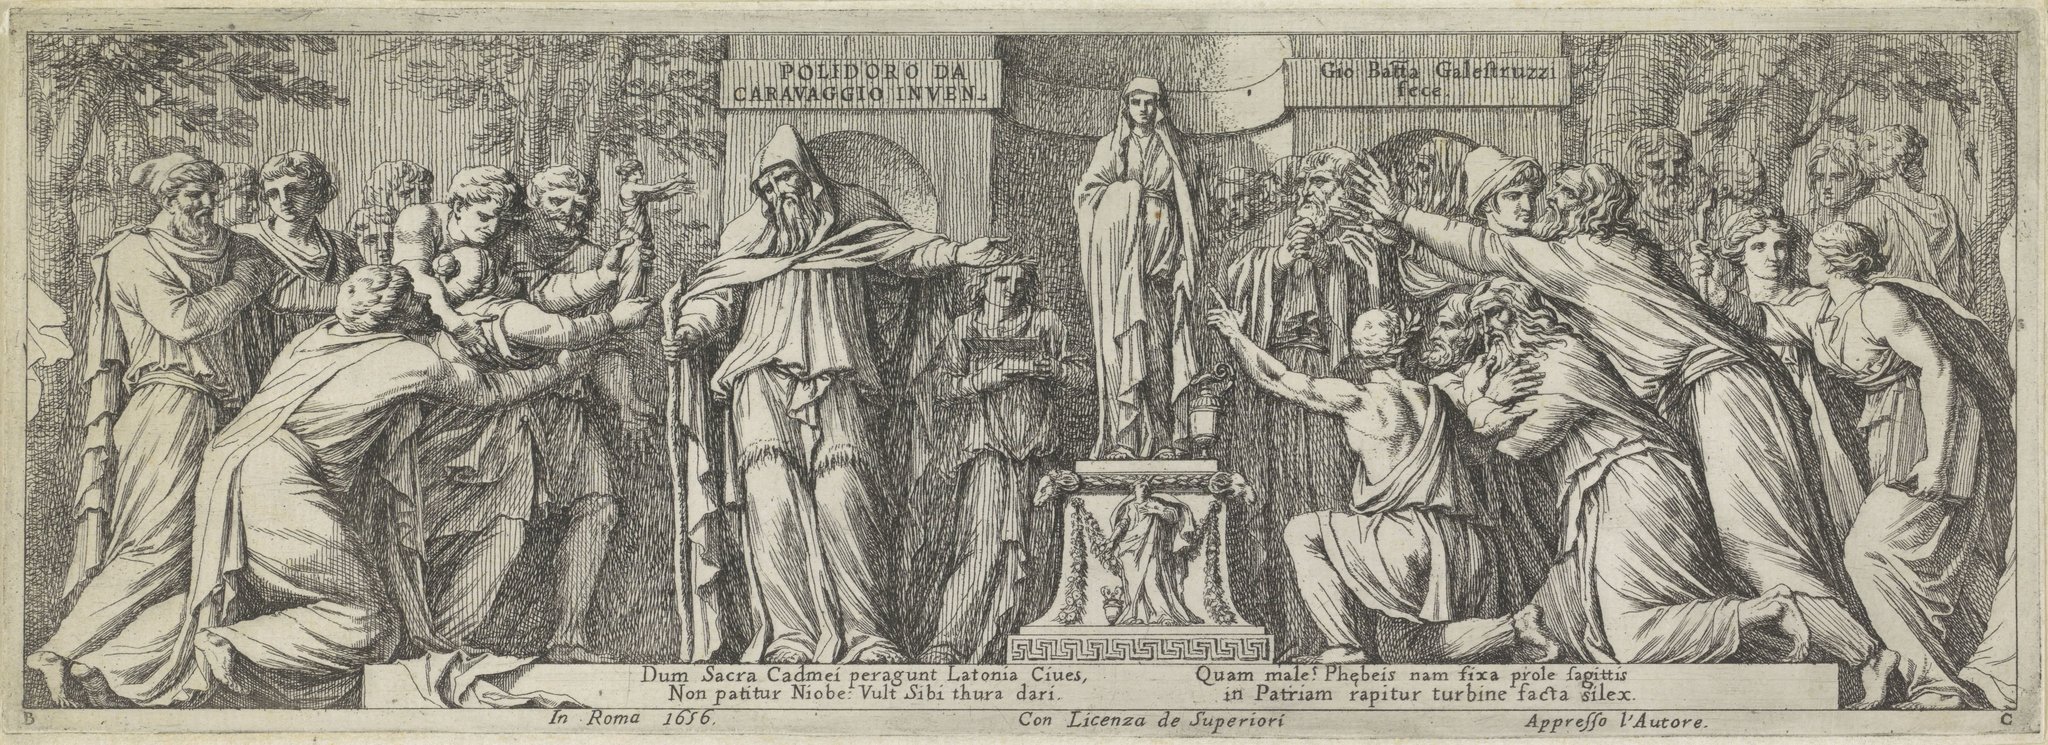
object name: print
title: Beeld van Niobe aanbeden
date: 1656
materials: paper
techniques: etching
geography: rome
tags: statues, paintings, etc. ~ objects of worship (non-christian religions), (story of) niobe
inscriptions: collector's mark: Lugt 240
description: Prent uit een reeks van vijf prenten over het leven van Niobe, die samen een fries vormen. Naar een fresco door Polidoro da Caravaggio op de façade van het Palazzo Milanesi te Rome.